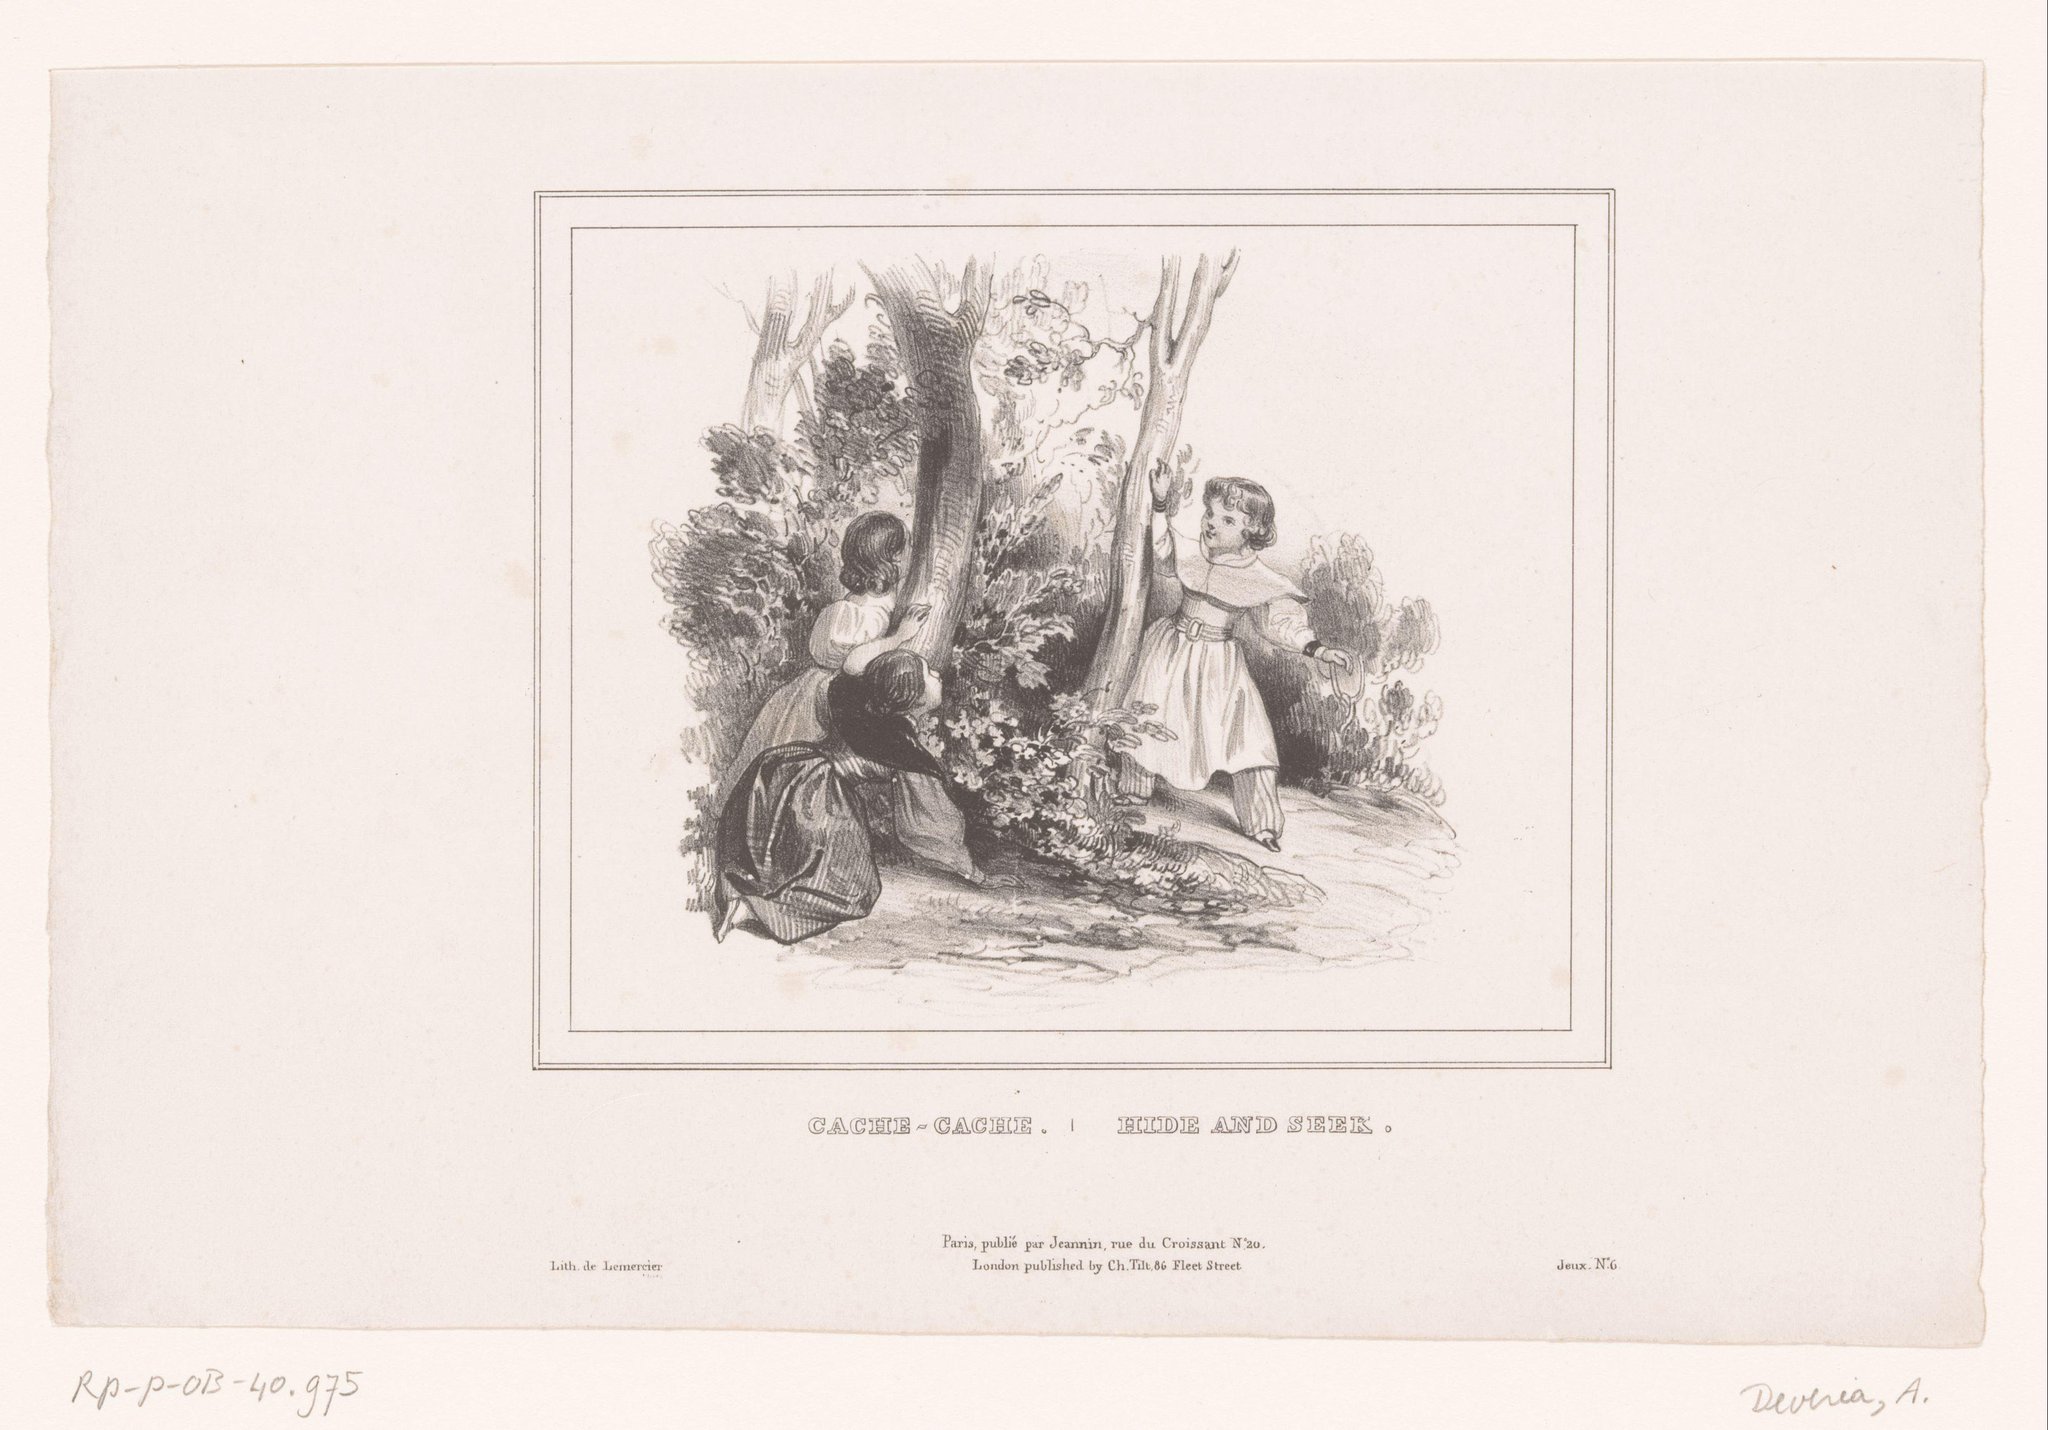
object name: print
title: Cache-chache / Hide and seek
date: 1832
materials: paper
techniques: lithograph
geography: paris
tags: hide-and-seek, child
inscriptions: collector's mark: Lugt 2166, check stamp: Lugt 1397c